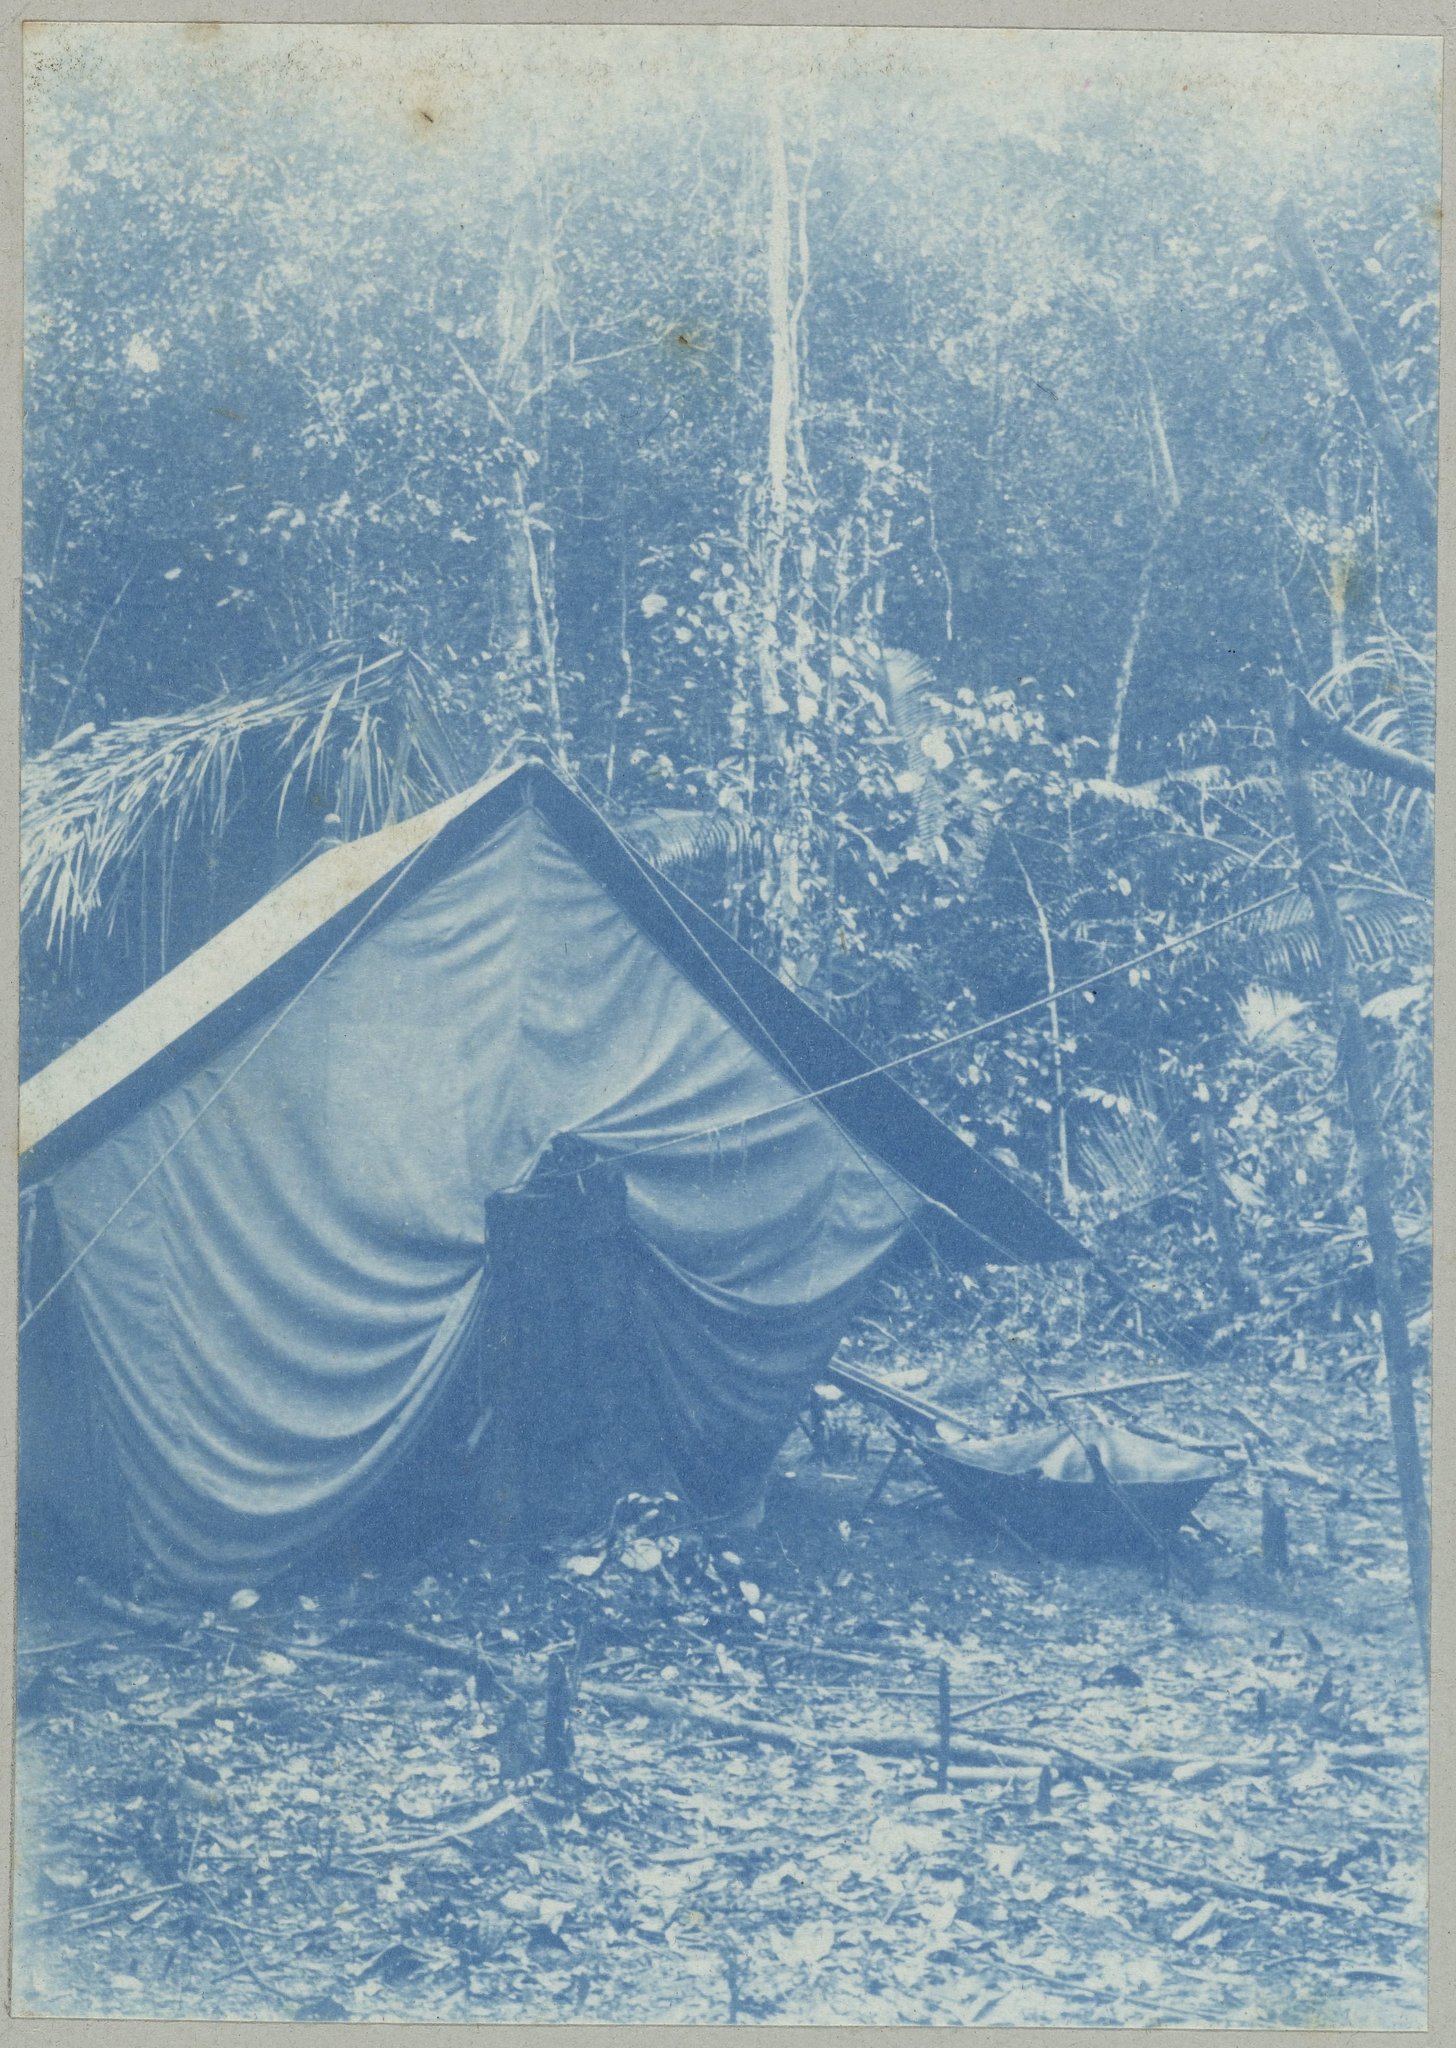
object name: photograph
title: Meetkamp met muskietentent aan de Saramaccakreek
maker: hendrik doijer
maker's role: engineer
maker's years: 1863-1925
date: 1903-1910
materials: photographic support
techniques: cyanotype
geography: suriname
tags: suriname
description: Een tent overspannen met een muskietennet, in het meetkamp in het oerwoud aan de Kleine Saramacca Rivier (Saramaccakreek). Onderdeel van het fotoalbum Souvenir de Voyage (deel 1), over het leven van de familie Doijer in en rond de plantage Ma Retraite in Suriname in de jaren 1903-1910.